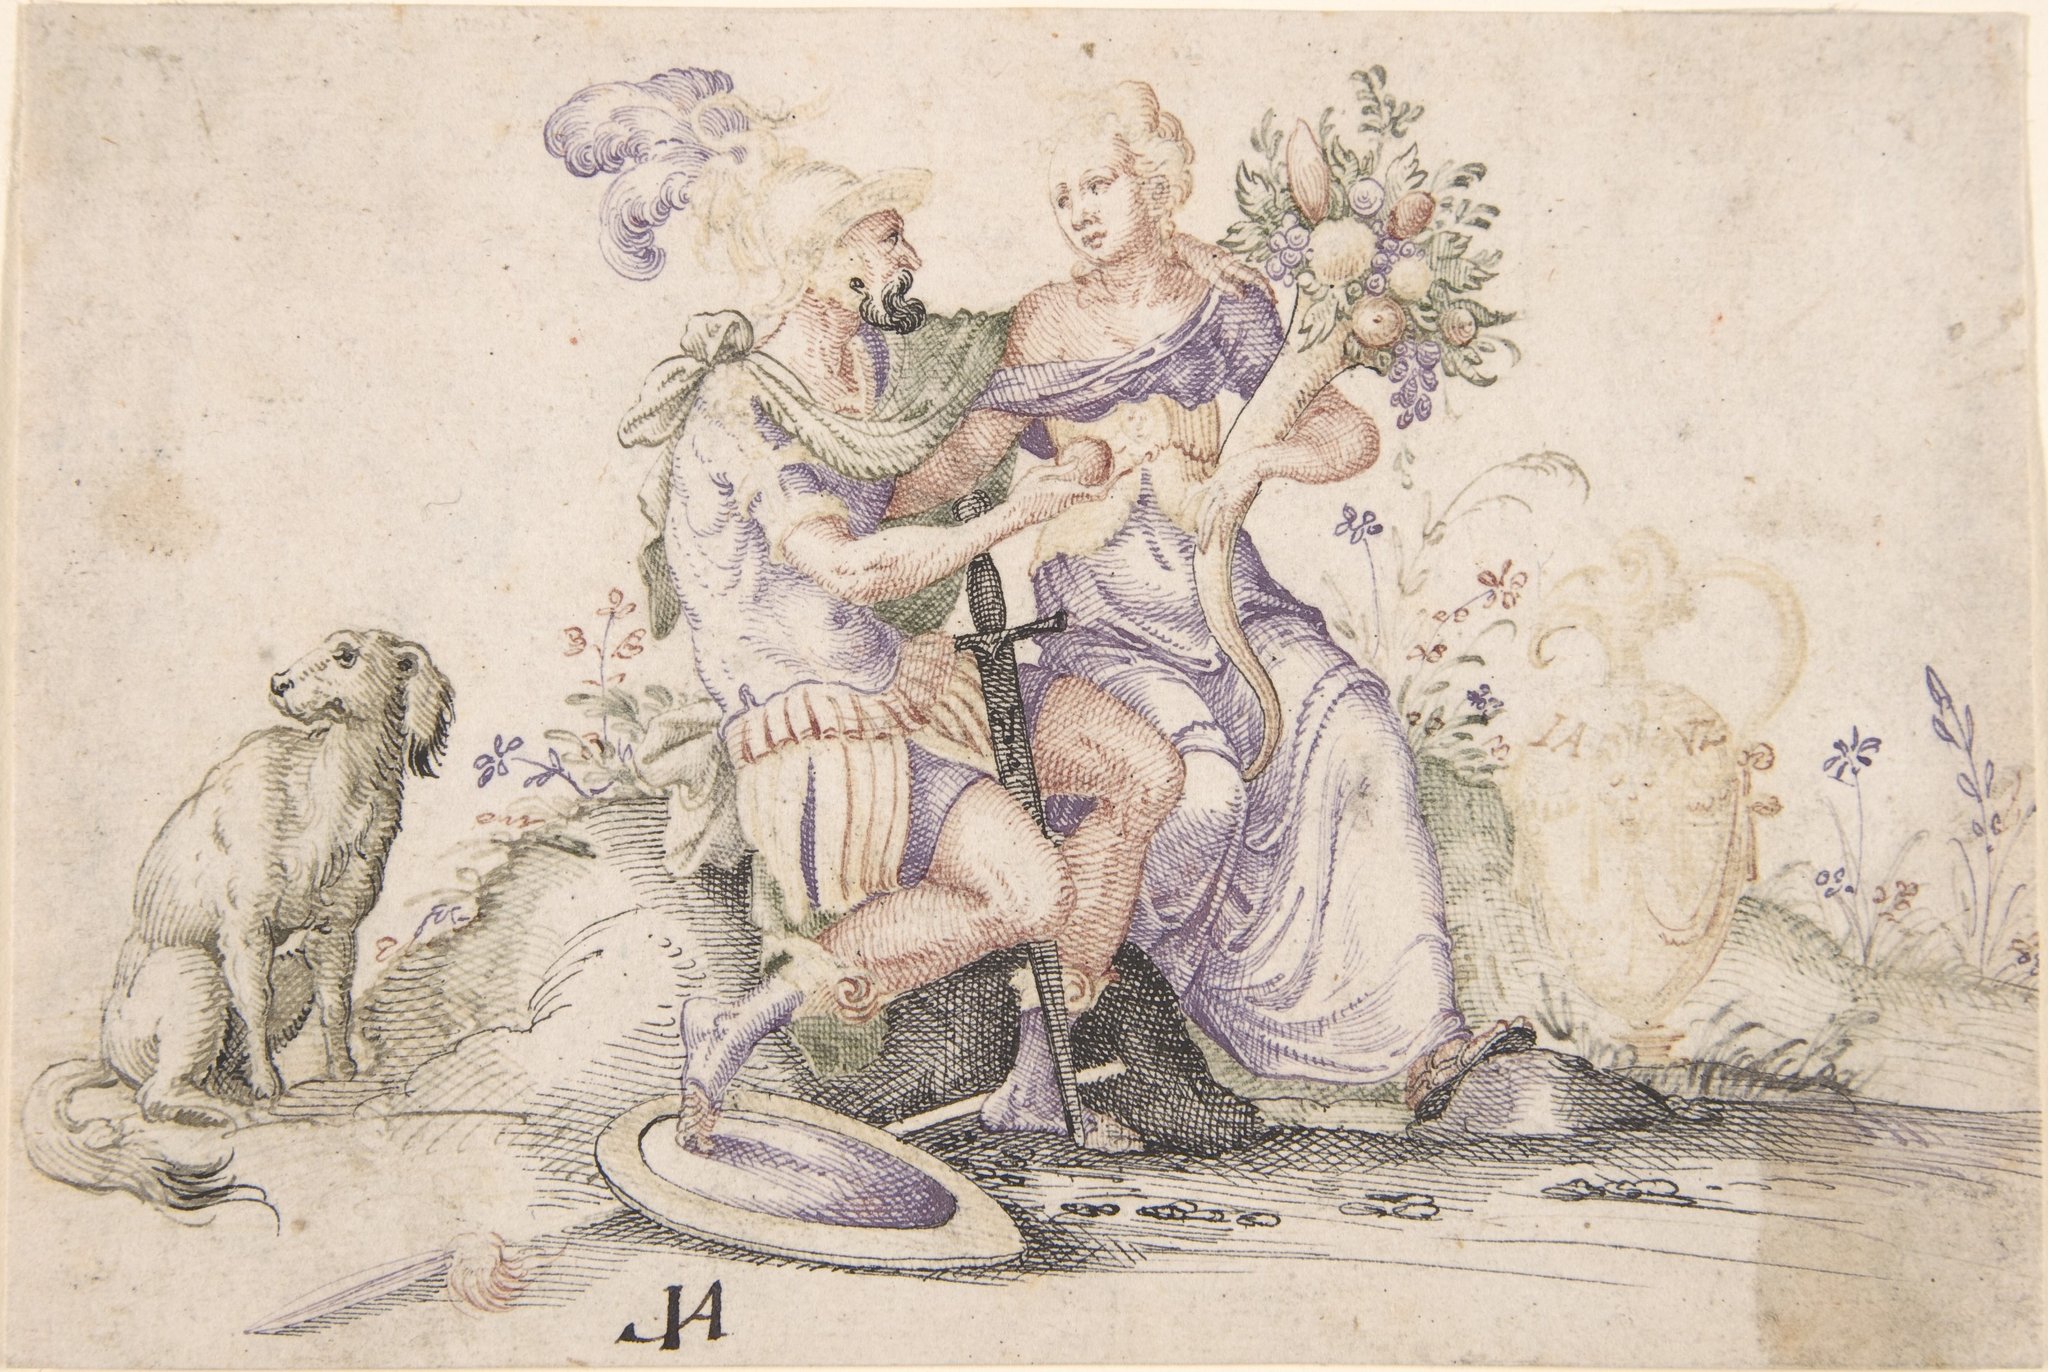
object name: drawing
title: Mars and Pomona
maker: jost amman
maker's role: artist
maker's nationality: swiss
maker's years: 1539-1591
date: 1539-1591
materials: ink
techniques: pen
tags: women,mars,dogs,flowers,leaves